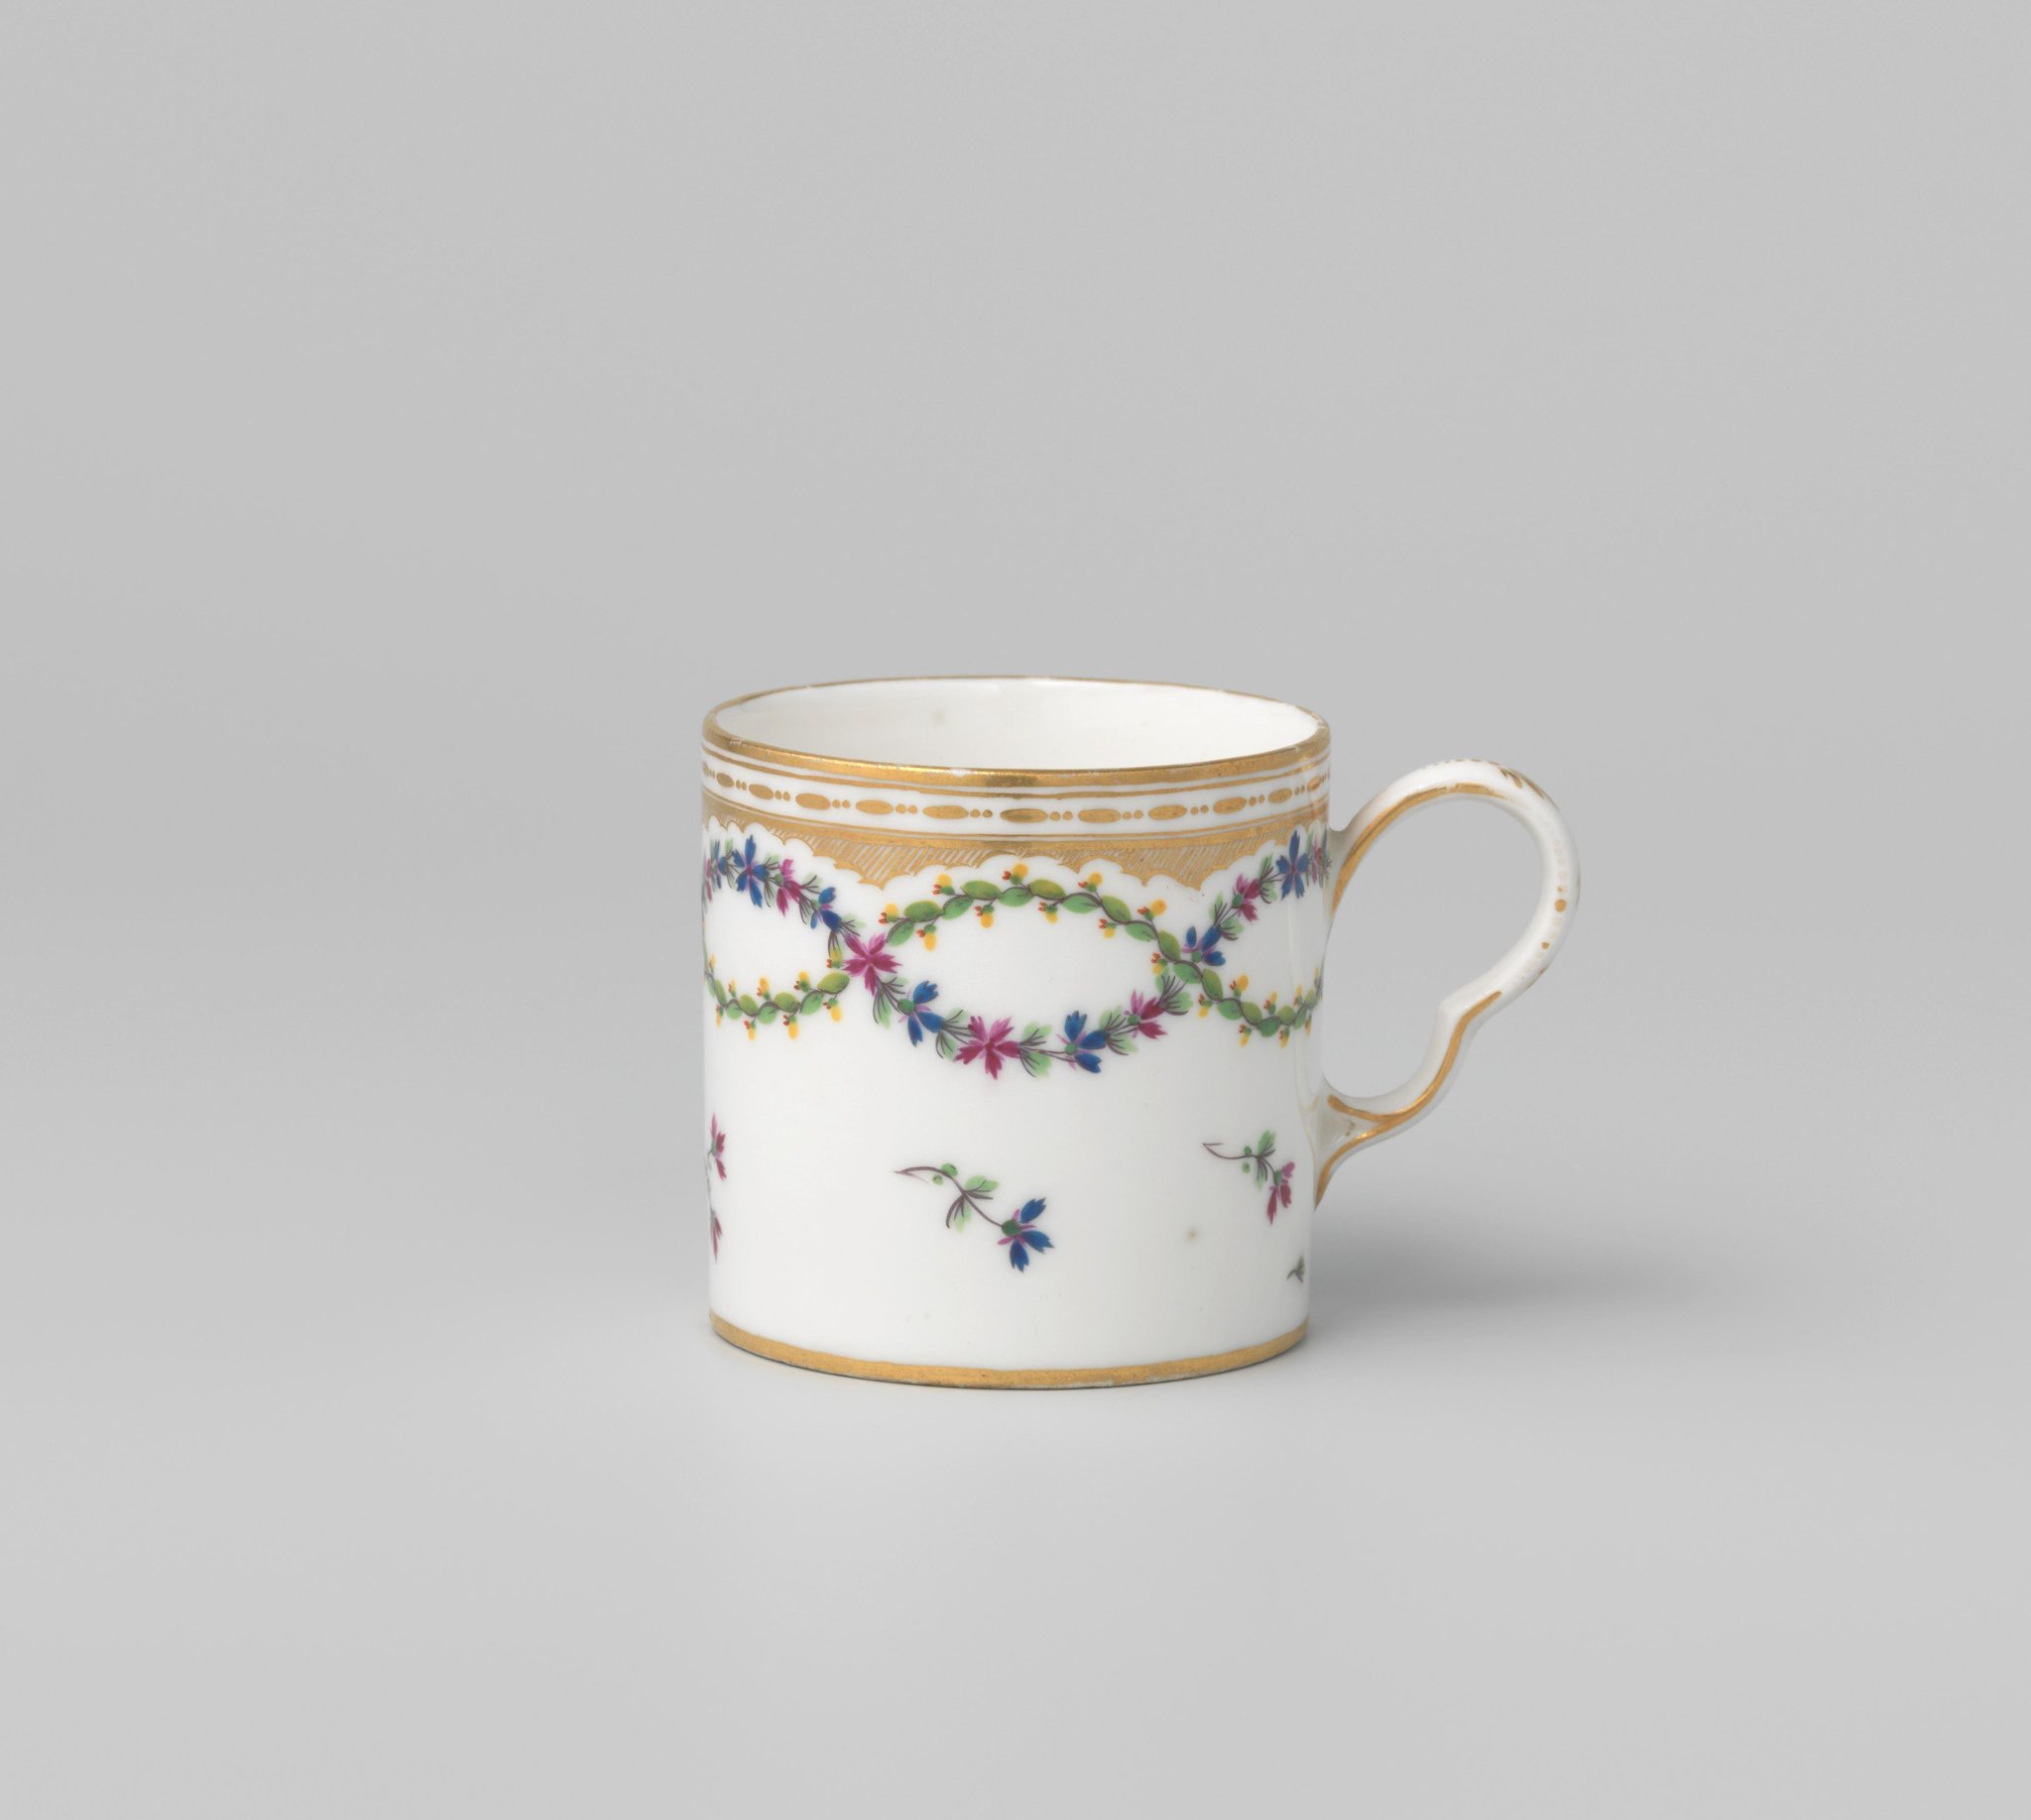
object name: cup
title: Cup with floral scrolls and flower sprays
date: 1775-1790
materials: glaze, gold, paint, porcelain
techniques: firing, gilding, turning, vitrification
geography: clignancourt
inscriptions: mark: ‘LSX’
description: Kop van porselein met een cilindrische wand en oor, beschilderd op het glazuur in blauw, rood, roze, groen, geel, paars en goud. Op de buitenwand enkele bloemtakken met daarboven twee elkaar kruisende bloemranken. Een decoratieve band op de rand. Stippen en bladmotieven op het oor. Gemerkt op de onderzijde met het monogram 'LSX'.